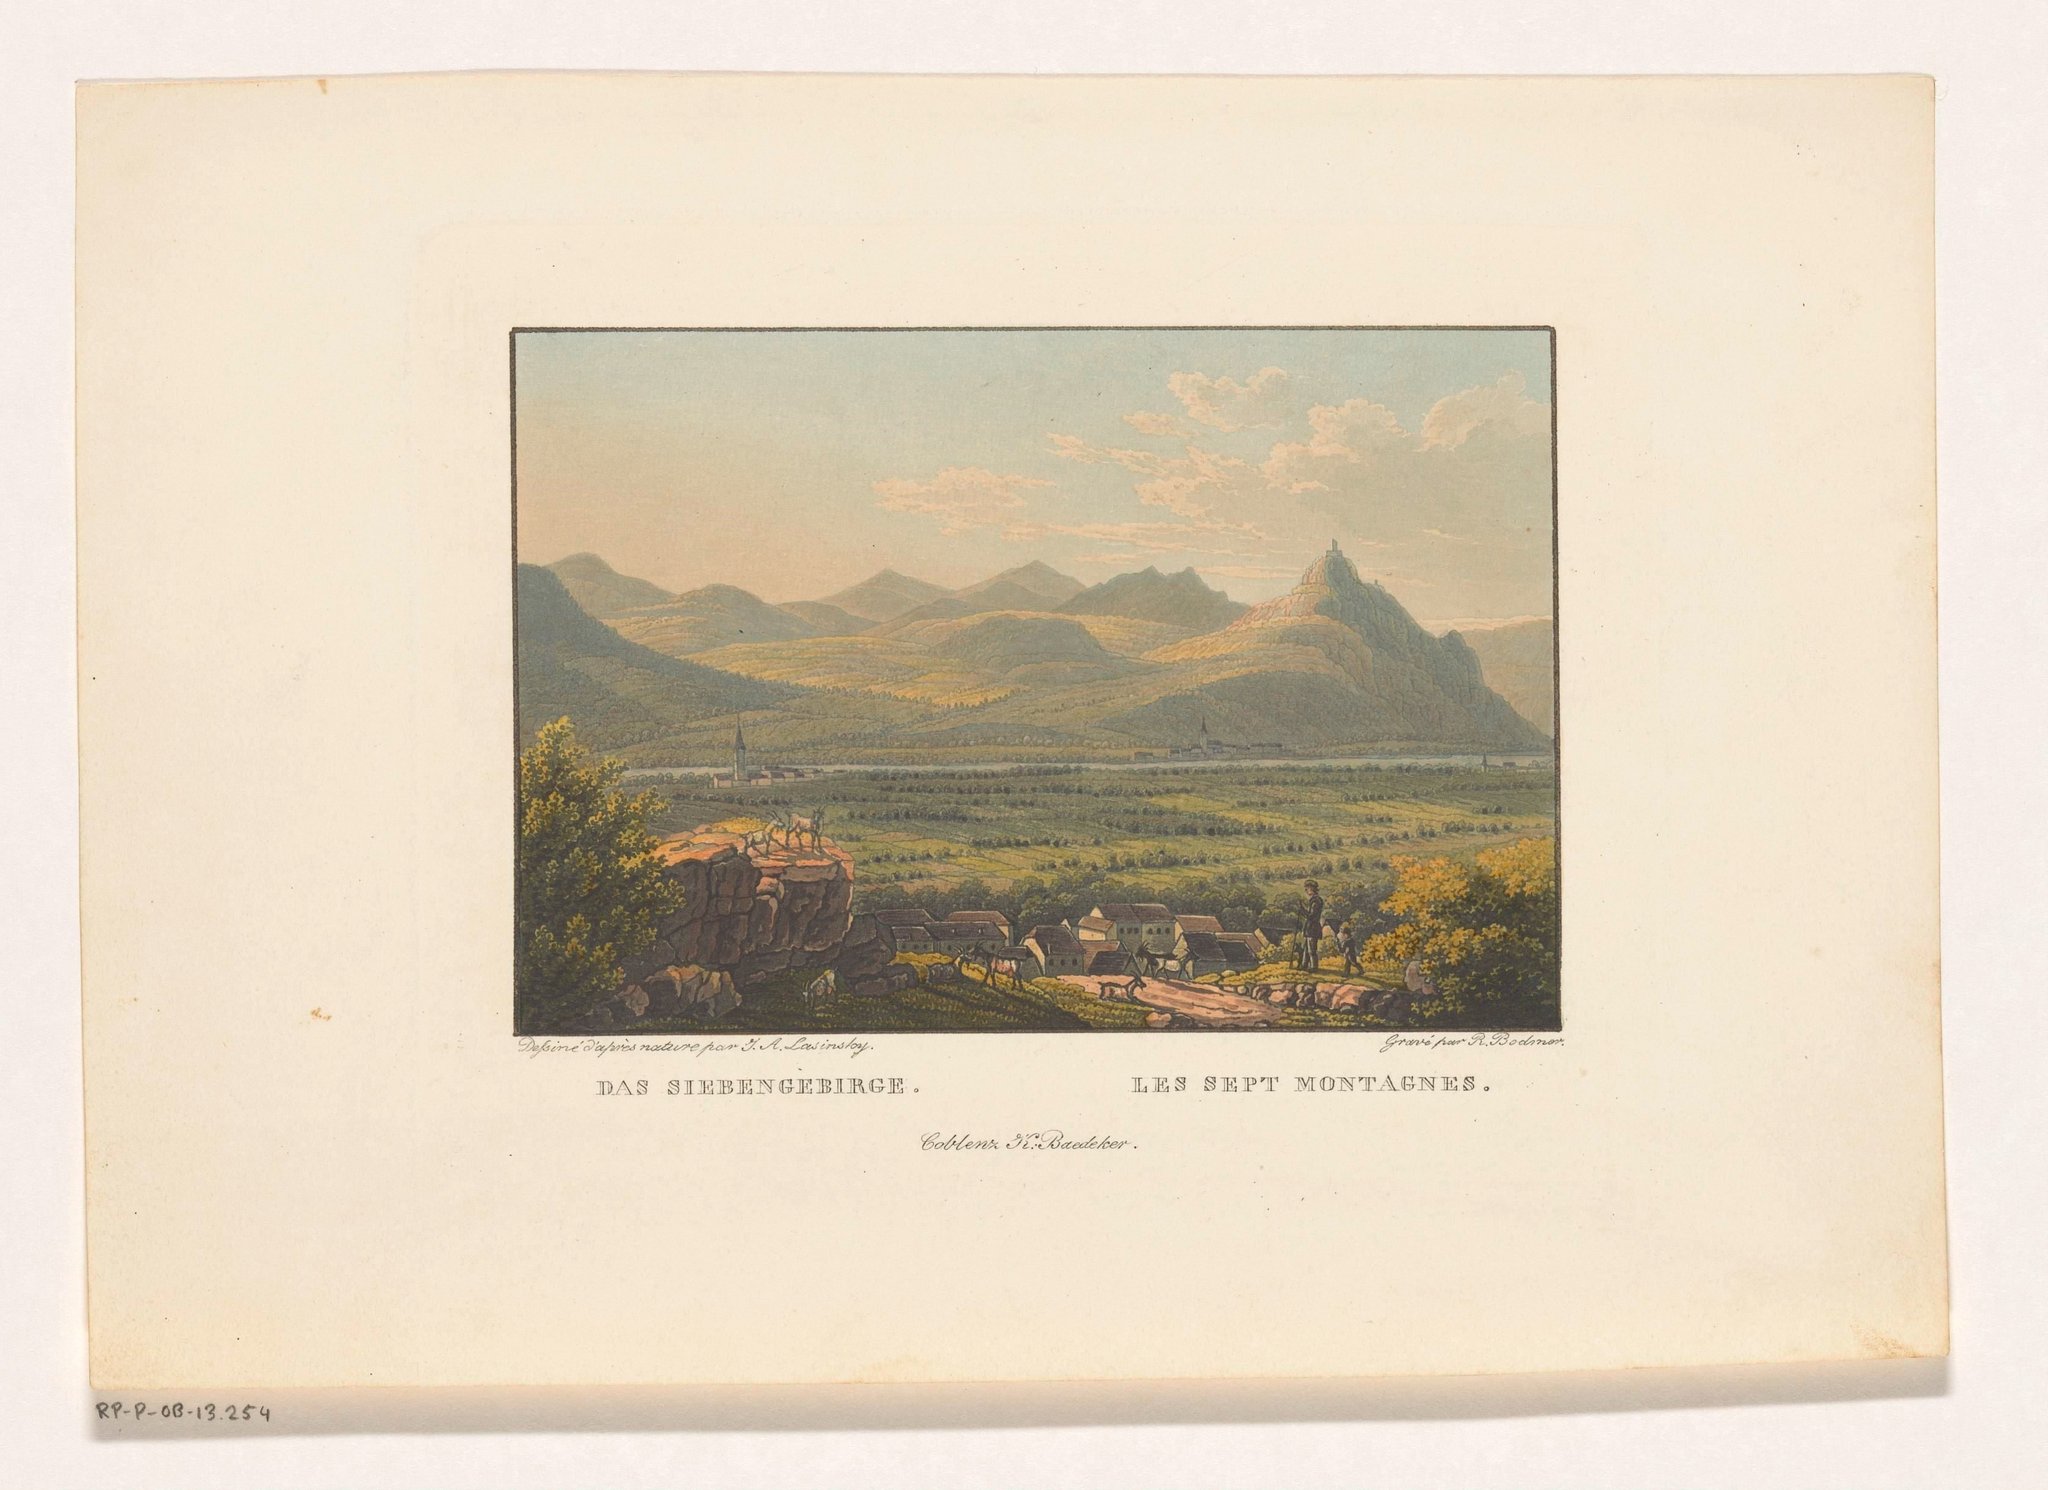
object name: print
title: Das Siebengebirge / Les sept montagnes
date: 1832-1872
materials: paper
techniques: hand coloring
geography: zurich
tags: zevengebergte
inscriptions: collector's mark: Lugt 2228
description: Vanaf 1828 verschenen bij Franz Friedrich Röhling in Koblenz verschillende uitgaven met prenten van burchten en kastelen gelegen langs de Rijn, vervaardigd door Rudolf Bodmer naar tekeningen van Adolf Lasinsky. Vanaf 1832 verschenen deze publicaties bij Karl Baedeker, die het fonds van Röhling had overgenomen.